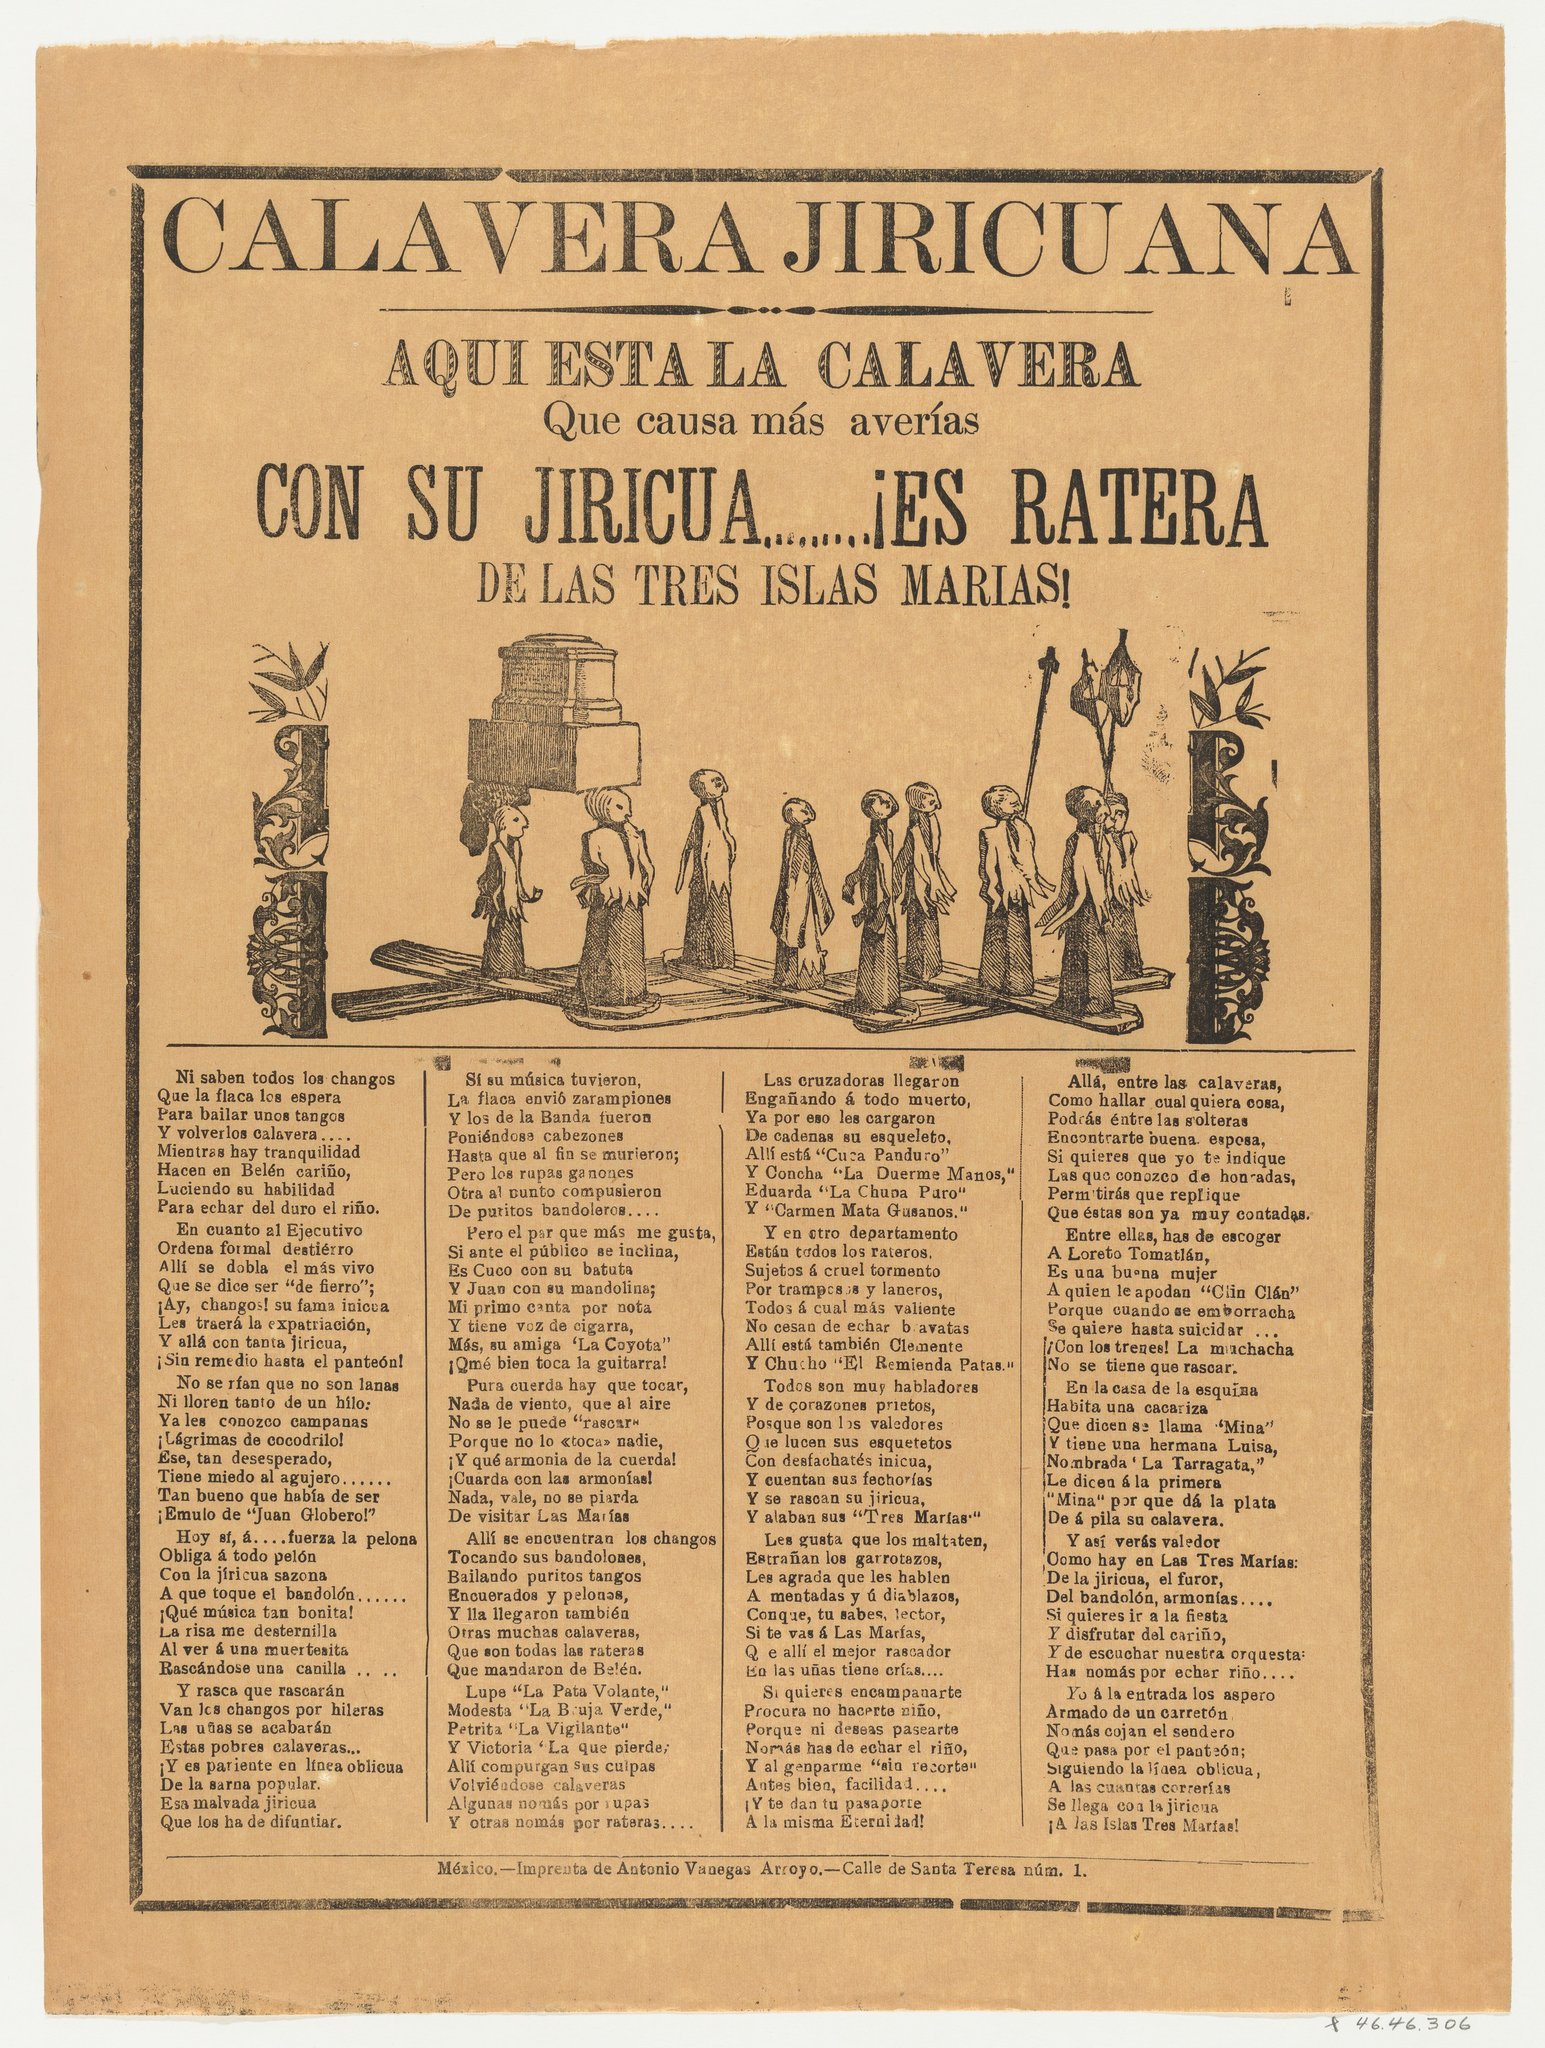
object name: print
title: Broadsheet relating to the calavero (skeleton) Jiricuana, a corrido (ballad) in the bottom section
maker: Anonymous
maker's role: artist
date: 1895-1910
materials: paper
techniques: letterpress